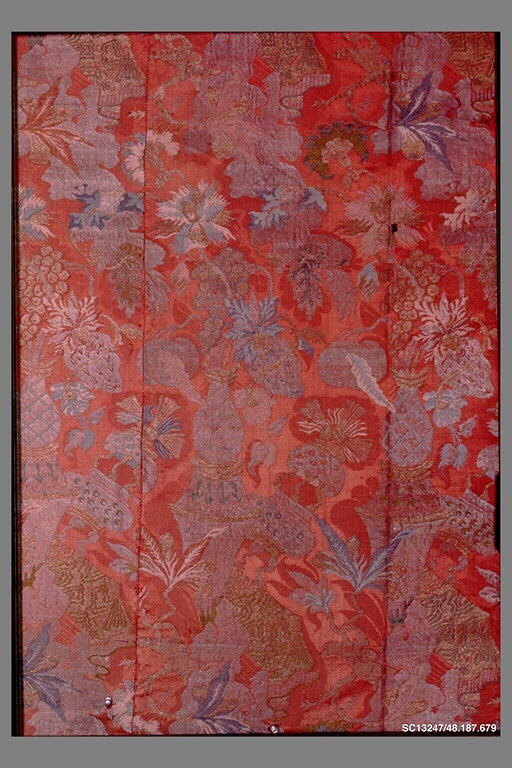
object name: piece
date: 1720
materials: metal thread, silk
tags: flowers